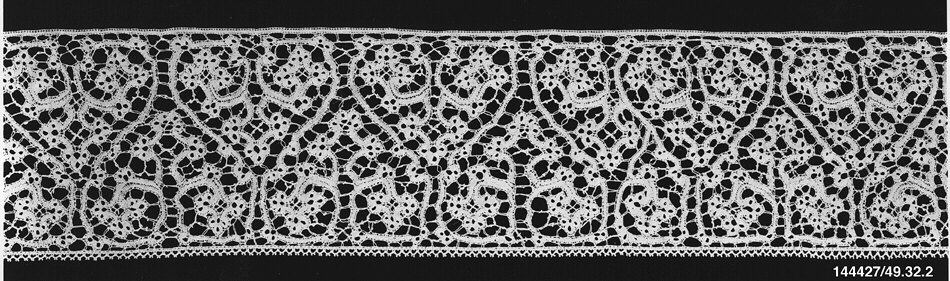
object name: border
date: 1601-1700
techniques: lace